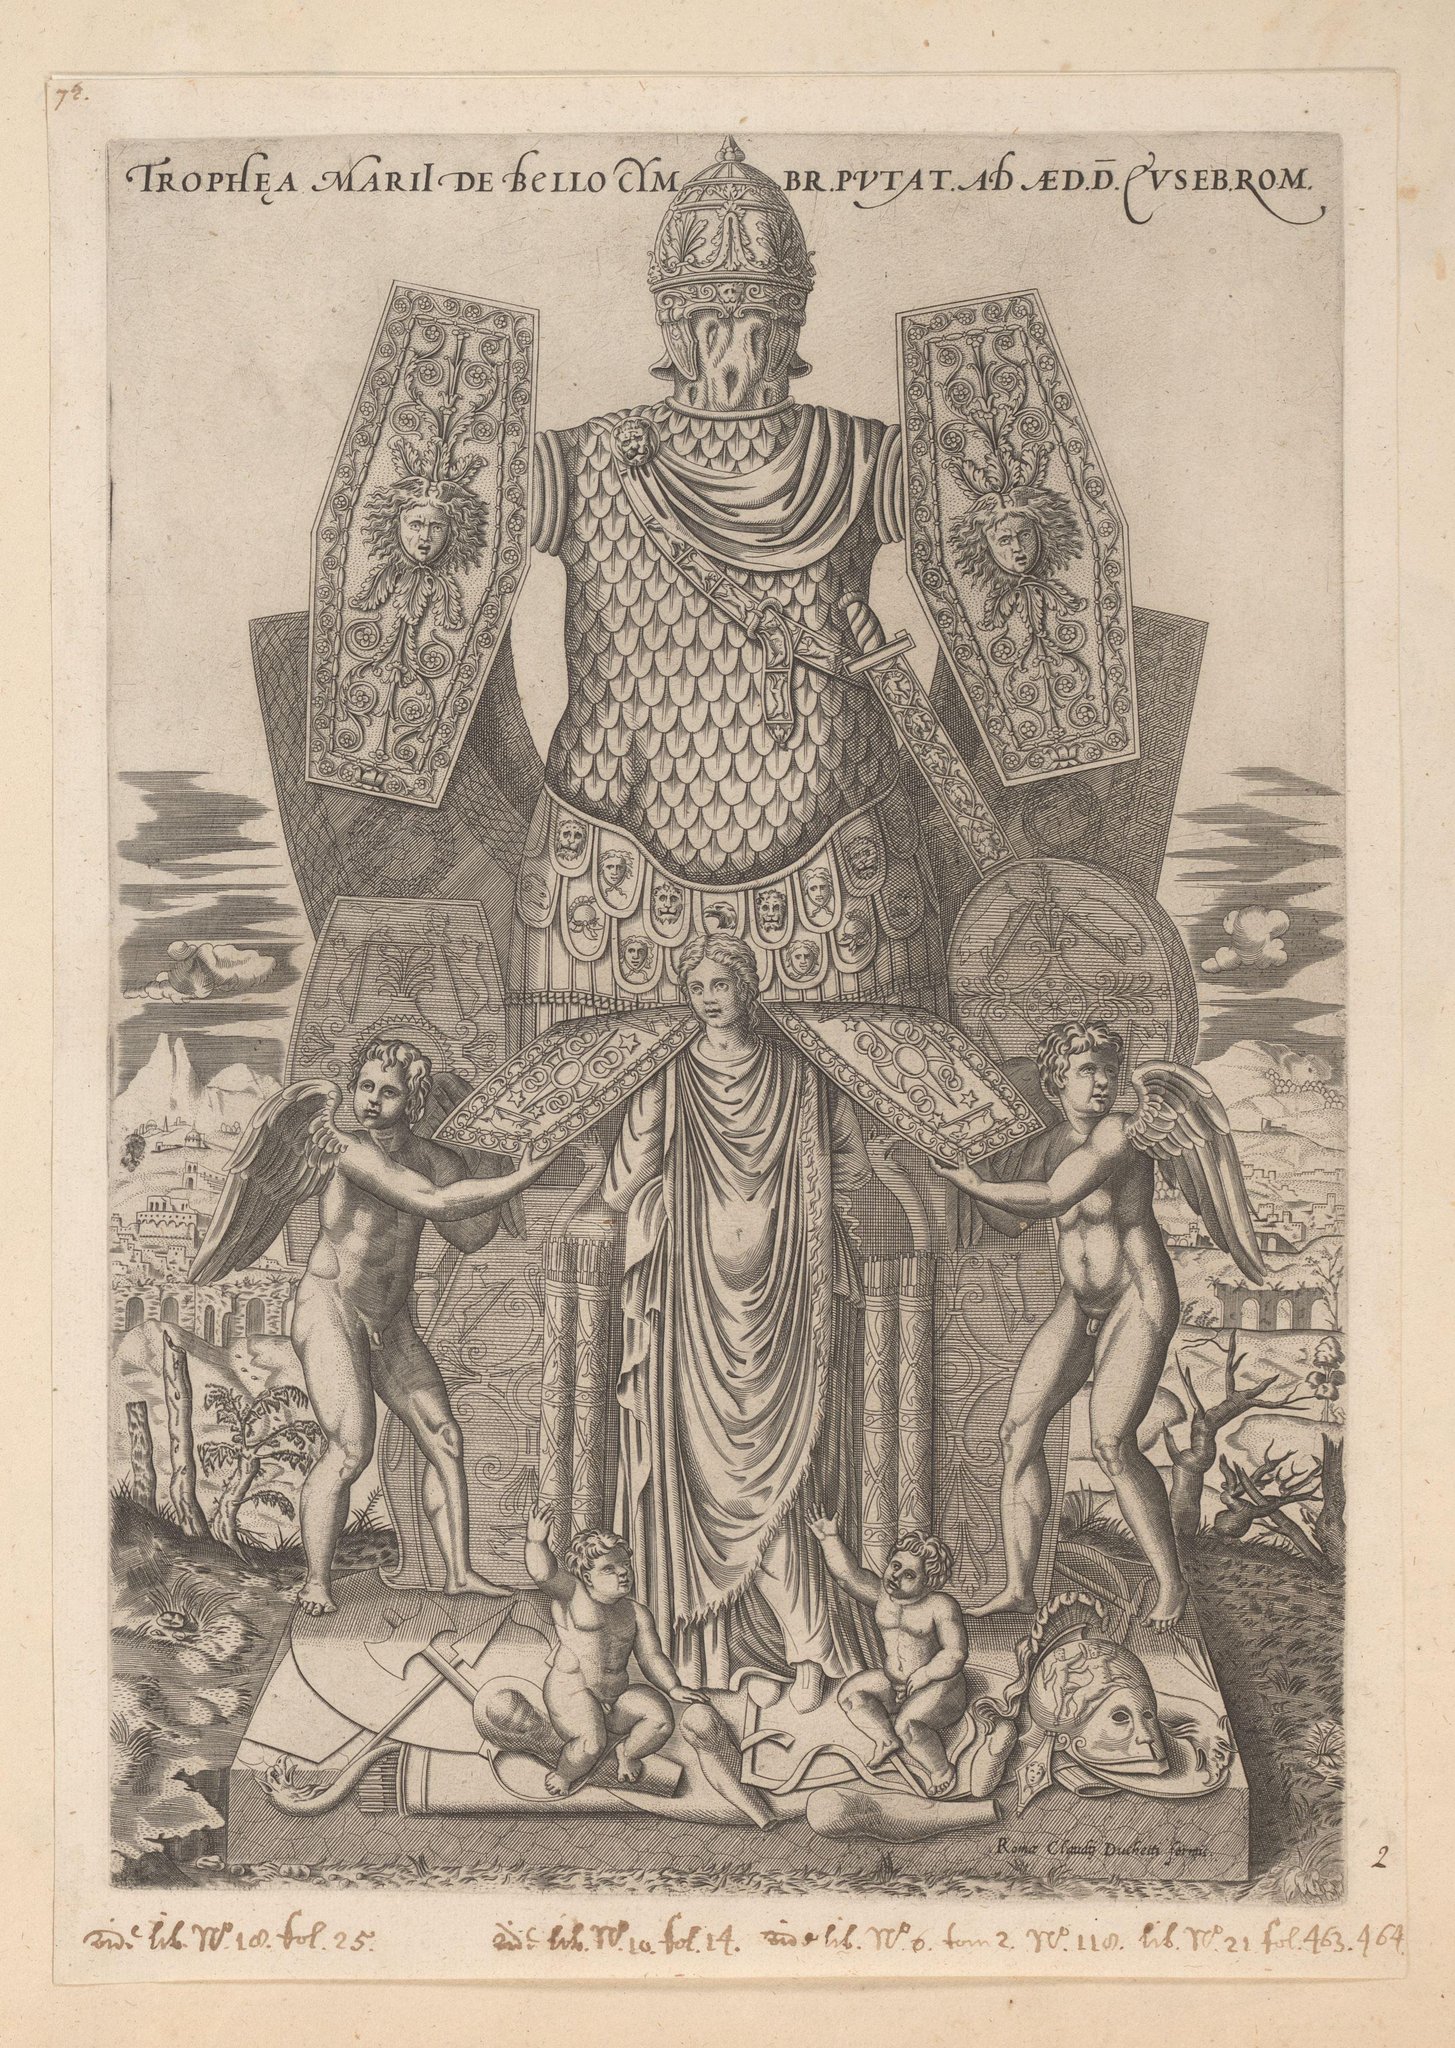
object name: album leaf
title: Trofee van Marius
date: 1572-1585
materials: paper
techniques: engraving, intaglio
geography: rome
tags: armour, trophy ~ battle, war, 'victoria'; 'vittoria', 'vittoria navale', 'vittoria degl'antichi' (ripa), piece of sculpture, reproduction of a piece of sculpture, cupids: 'amores', 'amoretti', 'putti'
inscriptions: number: ‘72’, inscription: ‘[...] lib. vol. 18. fol. 25. [...] lib. vol. 10. fol. 14 [...] lib. vol. 6. [...] 2. vol. 118. lib. vol. 21. fol. 463. 464.’, number: ‘2’, number: ‘81’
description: Deze prent behoort tot het prentcorpus dat bekend staat als de ‘Speculum Romanae Magnificentiae’ (‘Spiegel van Romeinse pracht’). Dit corpus, bestaande uit prenten met voorstellingen van kunstwerken en gebouwen uit het antieke en het moderne Rome, vond zijn oorsprong bij uitgevers Antonio Salamanca en Antonio Lafreri. Deze twee buitenlandse uitgevers bundelden hun krachten te Rome in de periode 1553-1563. Hun prenten werden al snel razend populair bij toeristen en verzamelaars, die de prenten individueel of in grote groepen aanschaften. Grote groepen Speculum-prenten werden vaak op aanvraag samengebonden in albums. Er zijn verschillende Speculum-albums overgeleverd die allemaal verschillen van inhoud. Tussen 1573 en 1577 gaf Antonio Lafreri een speciale titelpagina uit (met de titel ‘Speculum Romanae Magnificentiae’) die mensen voor hun verzamelingen konden voegen. Het overlijden van Lafreri in 1577 betekende niet het einde van het corpus. Een groot deel van de koperplaten ging over op Claudio en Stefano Duchetti. De rest raakte verspreid over verschillende andere uitgevers. De populariteit van de Speculum-prenten wist nog geruime periode uitgevers te inspireren tot het laten maken van kopieën en het toevoegen van nieuwe prenten aan het corpus.